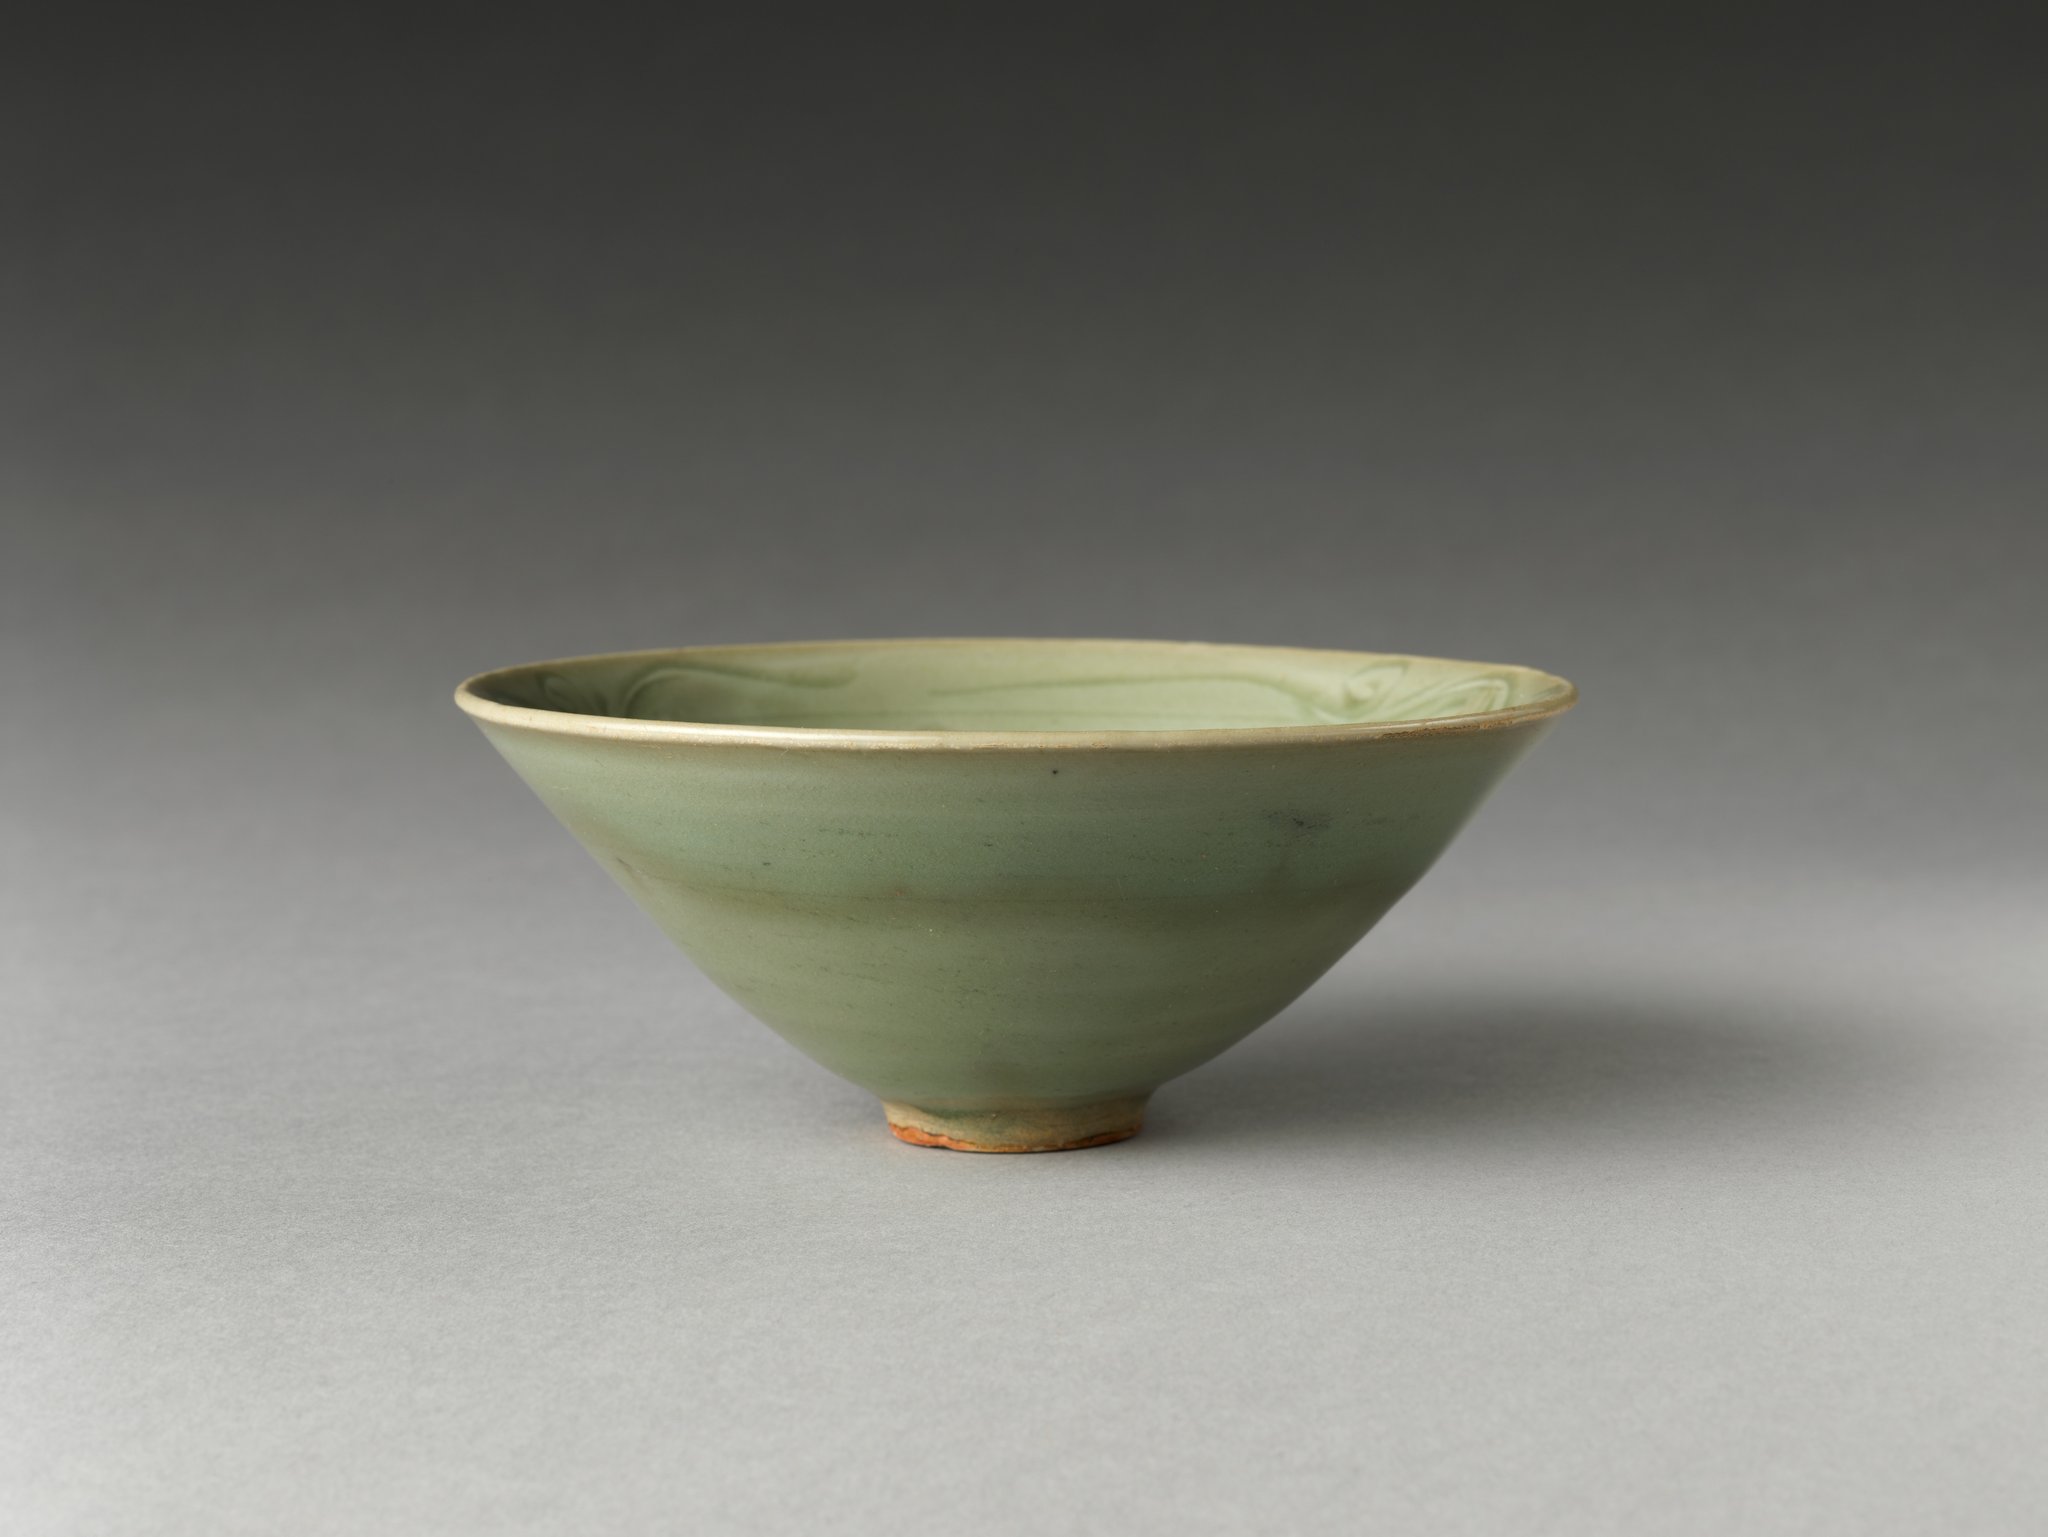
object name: bowl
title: Bowl with Plum Blossom and Crescent Moon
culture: chinese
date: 1267-1400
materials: ceramic glaze, glaze, porcelain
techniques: incising